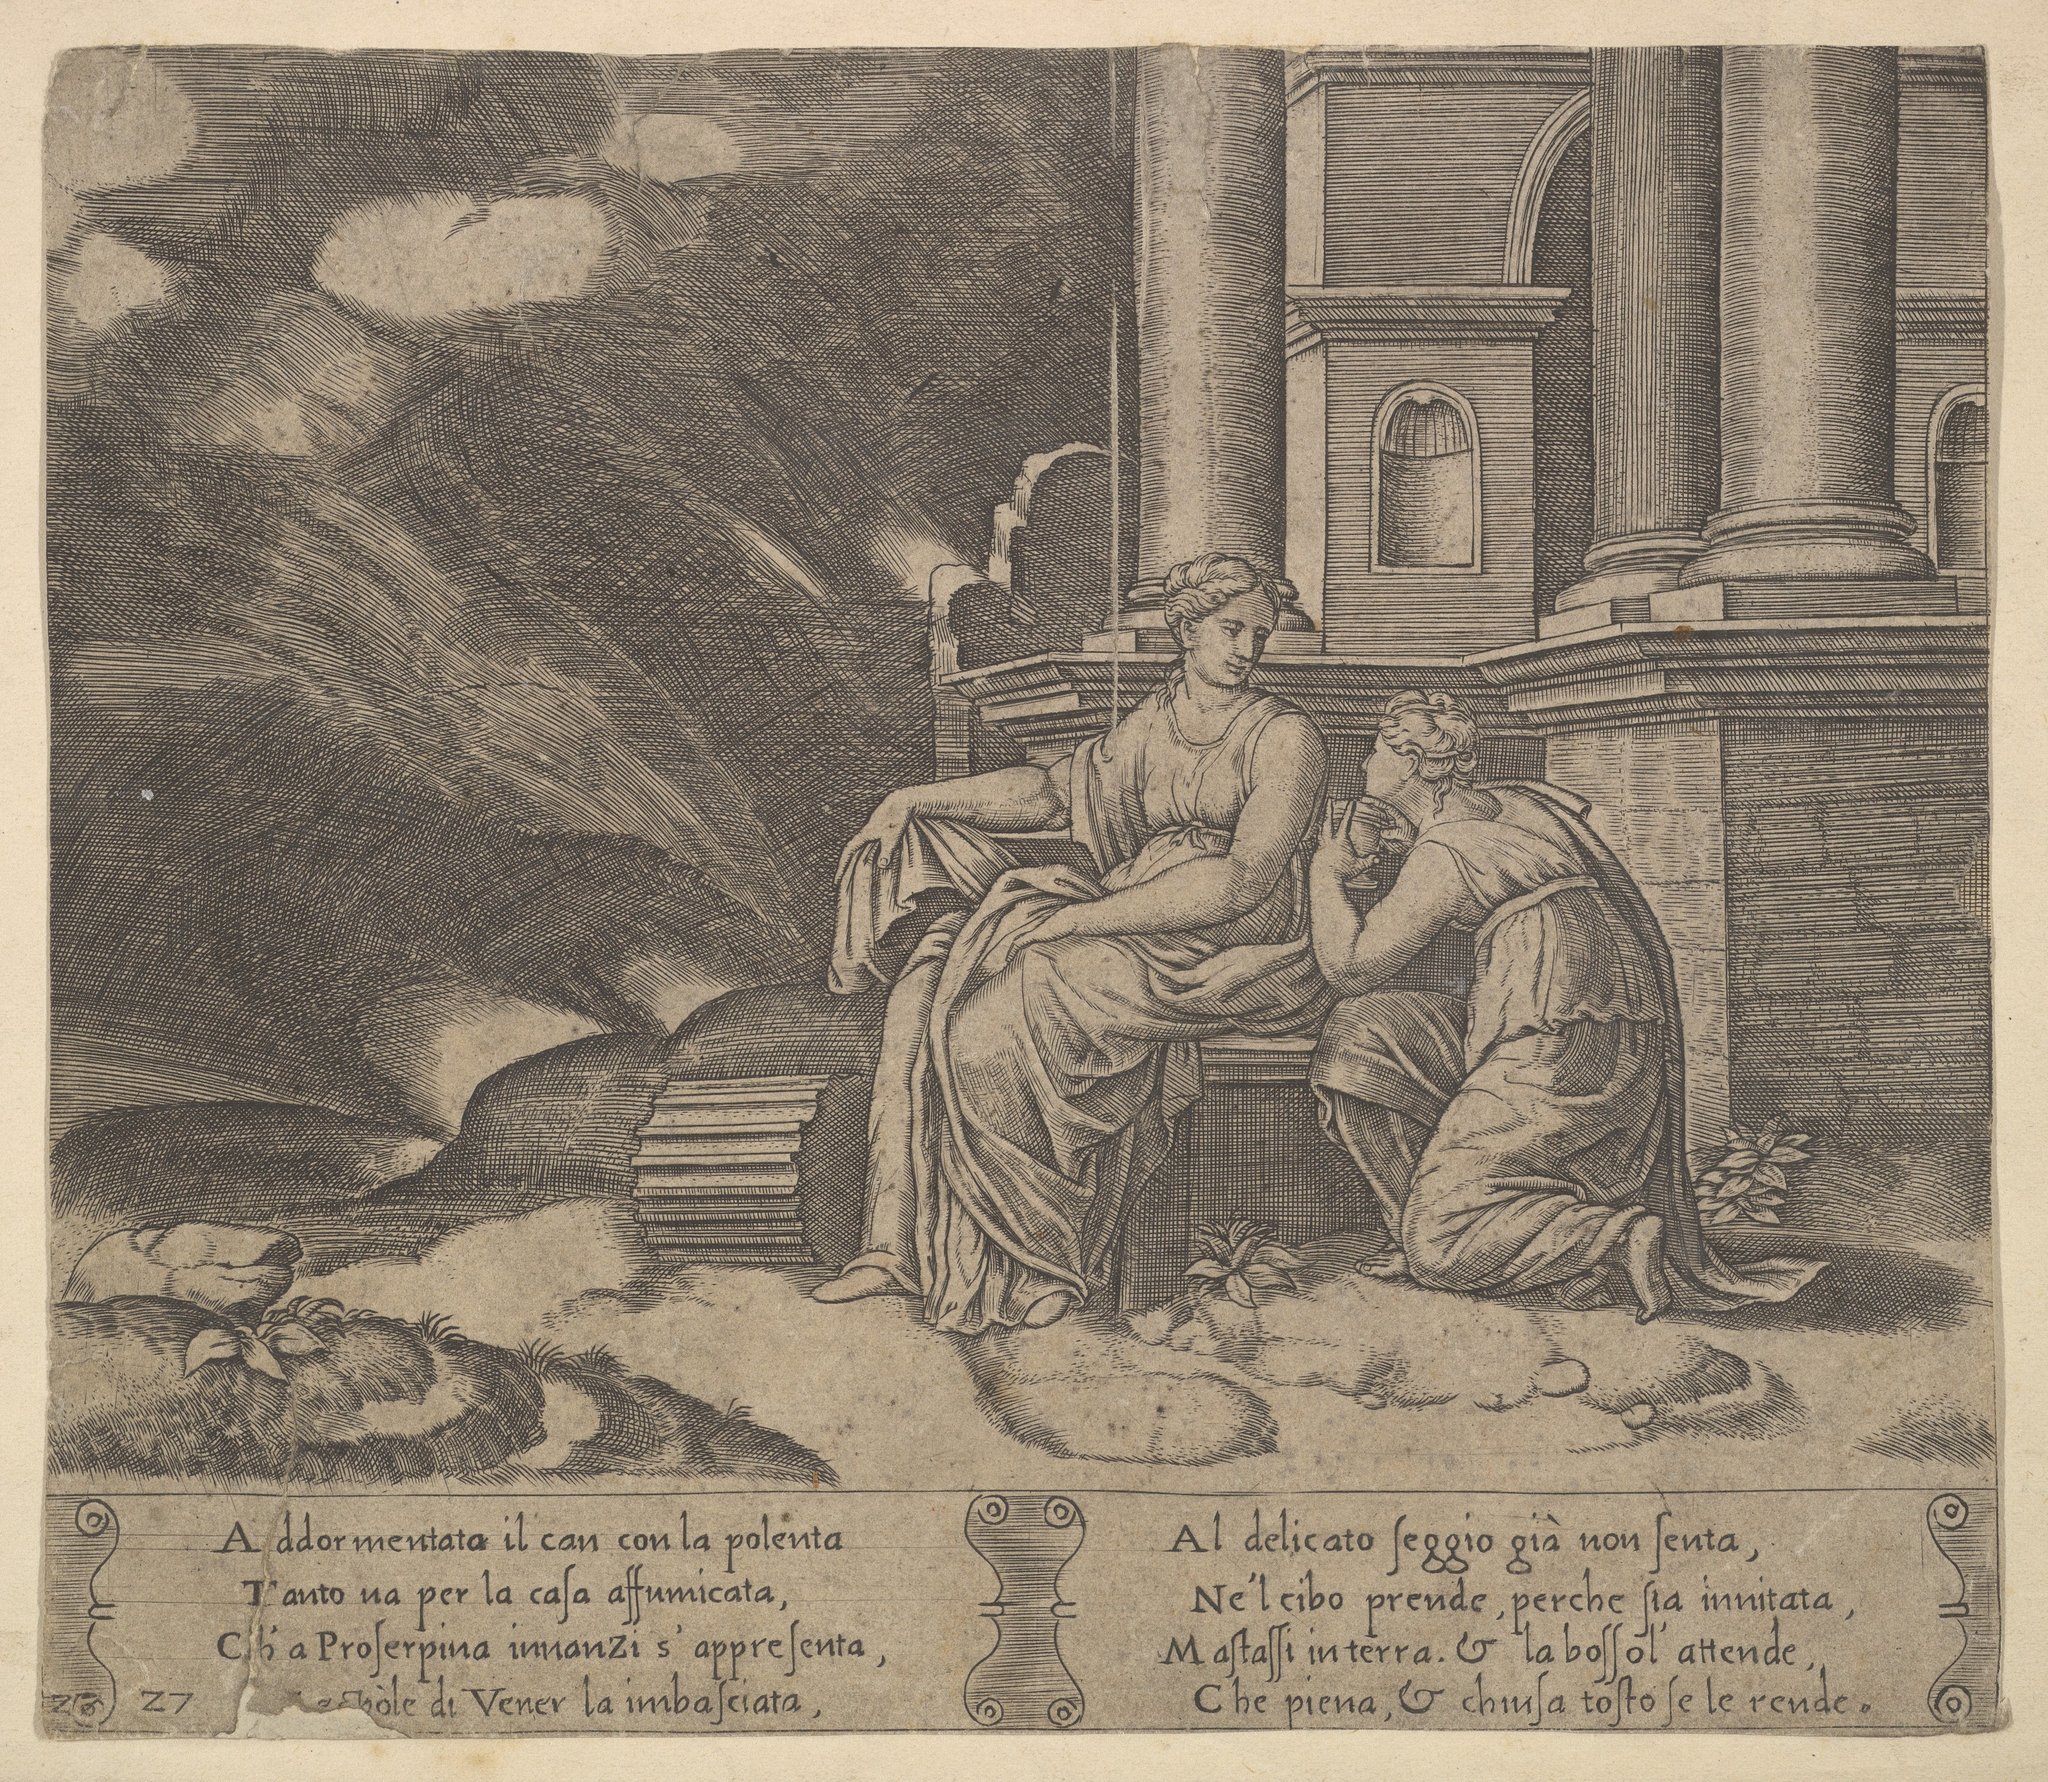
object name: print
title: Plate 27: Proserpina gives Psyche the box of beauty, from 'The Fable of Cupid and Psyche'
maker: master of the die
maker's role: artist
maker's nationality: italian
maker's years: 1525-1560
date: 1530-1560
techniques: engraving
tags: women,psyche